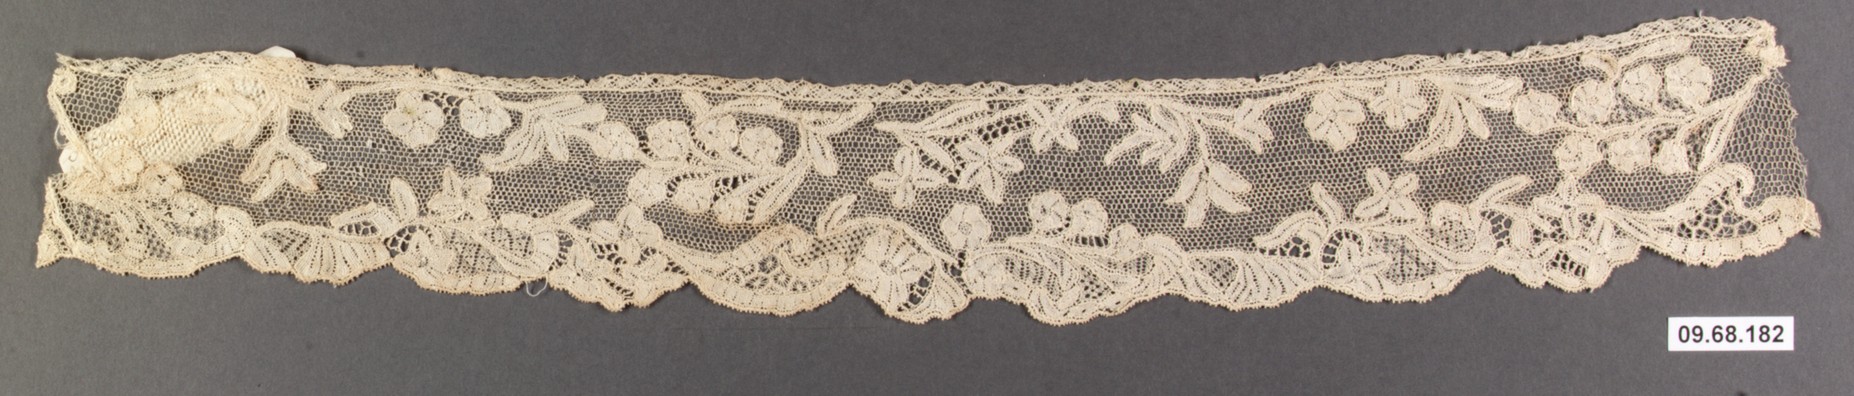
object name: strip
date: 1701-1800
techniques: lace